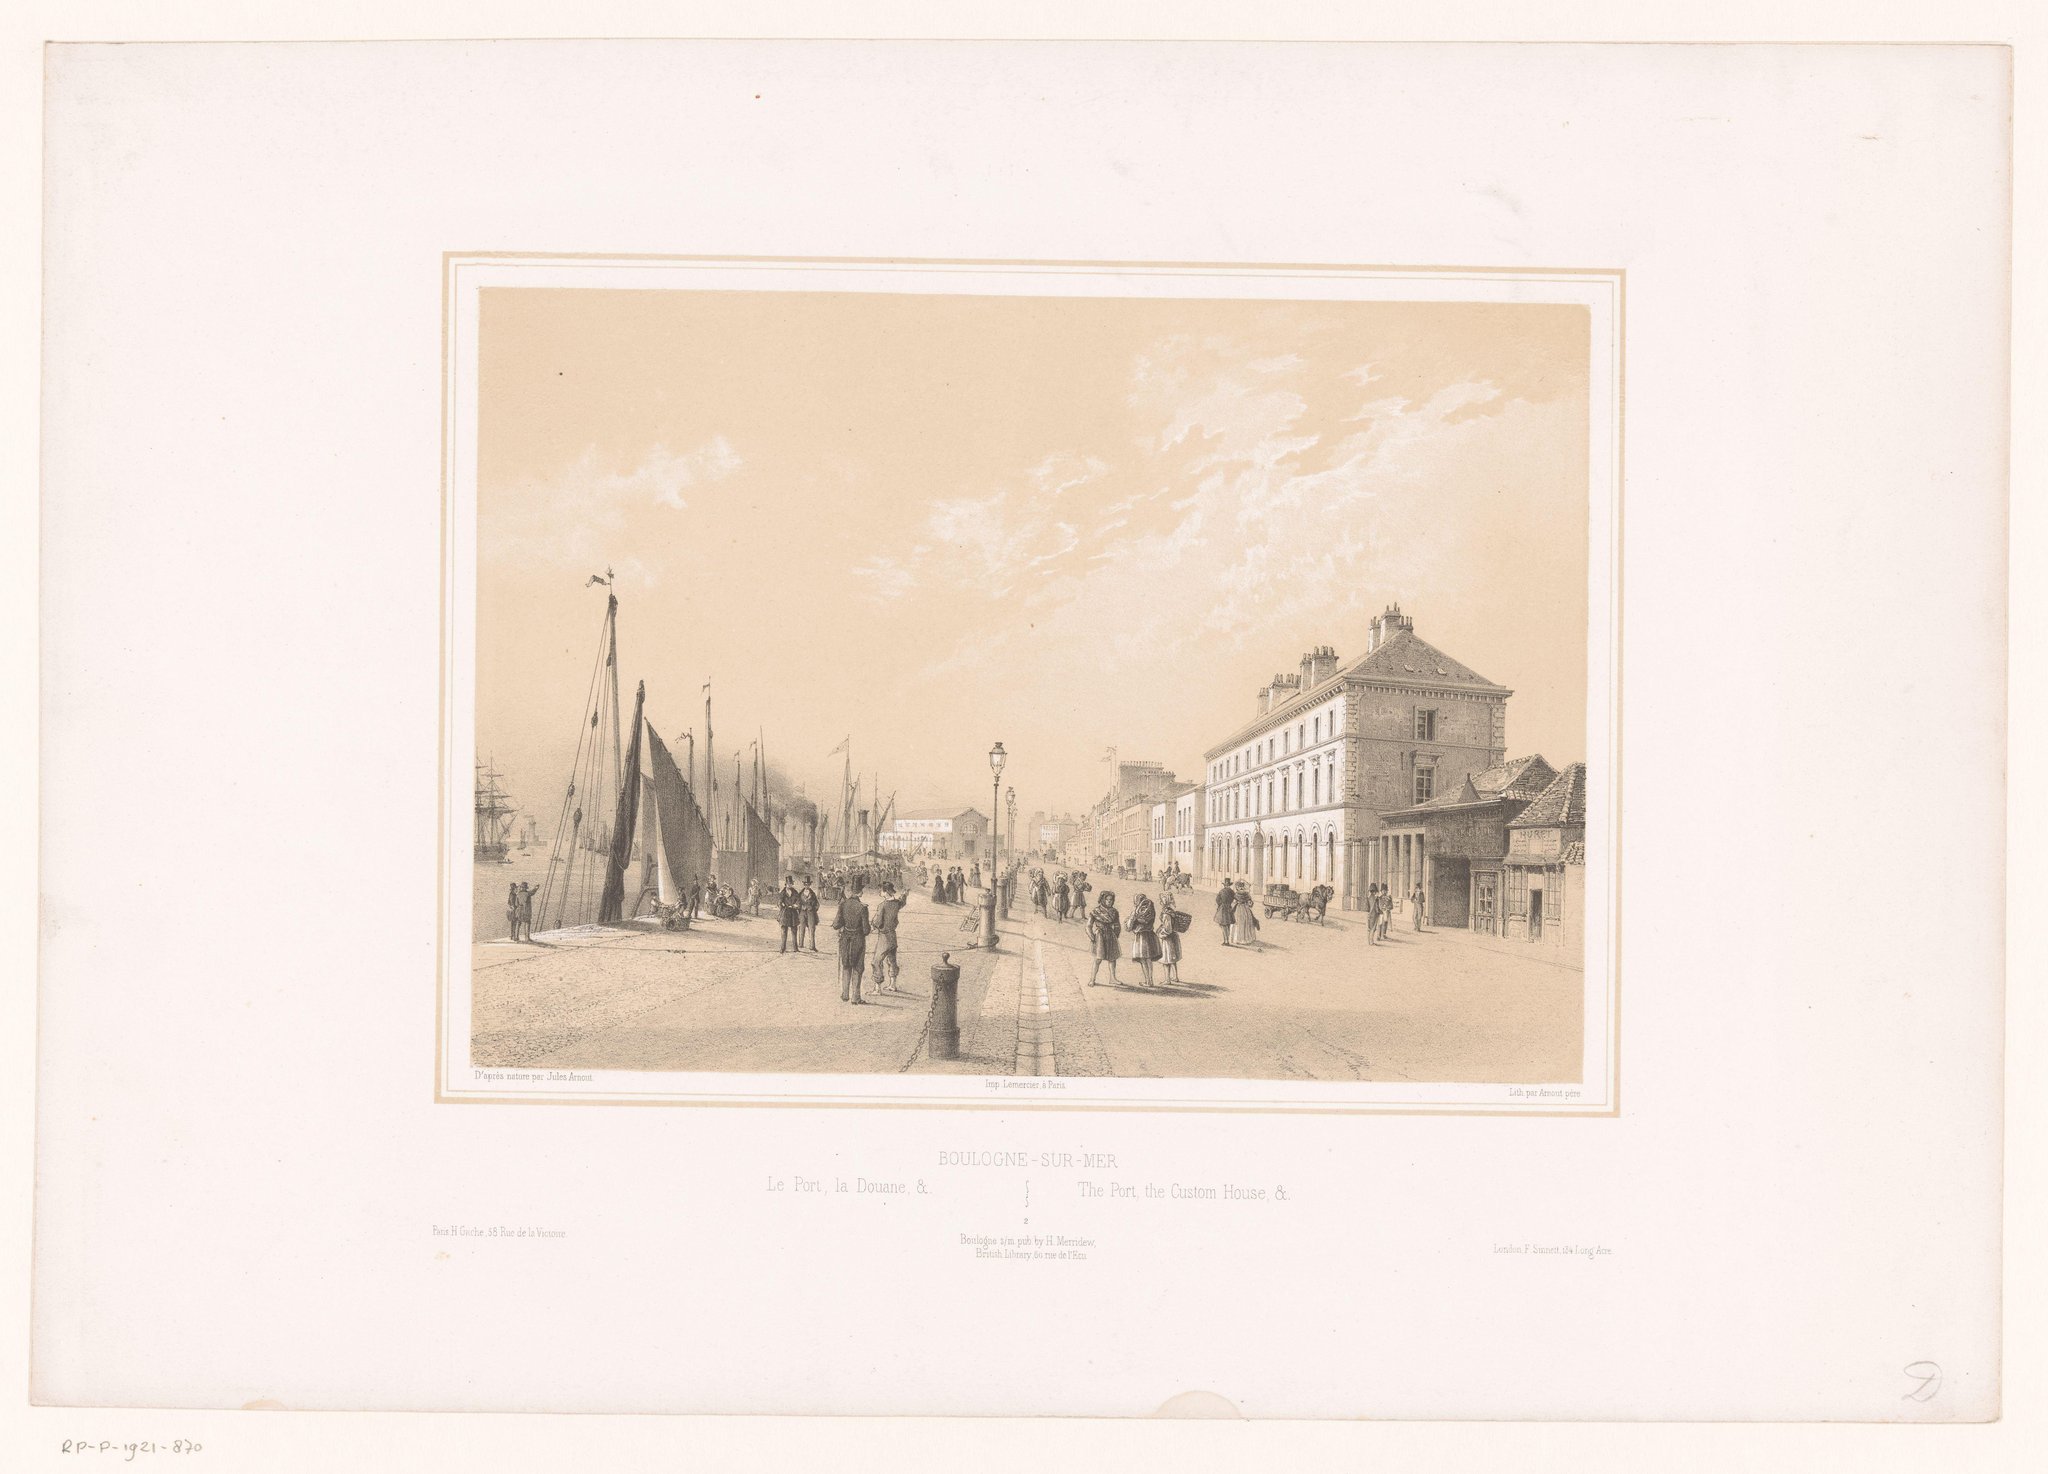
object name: print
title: Zicht op de haven en het douanekantoor van Boulogne-sur-Mer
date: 1847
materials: paper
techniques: tone lithography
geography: paris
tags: harbour, customs, avenue, boulevard, promenade, esplanade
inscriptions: collector's mark: Lugt 2233, collector's mark: Lugt 2228, check stamp: Lugt 3977